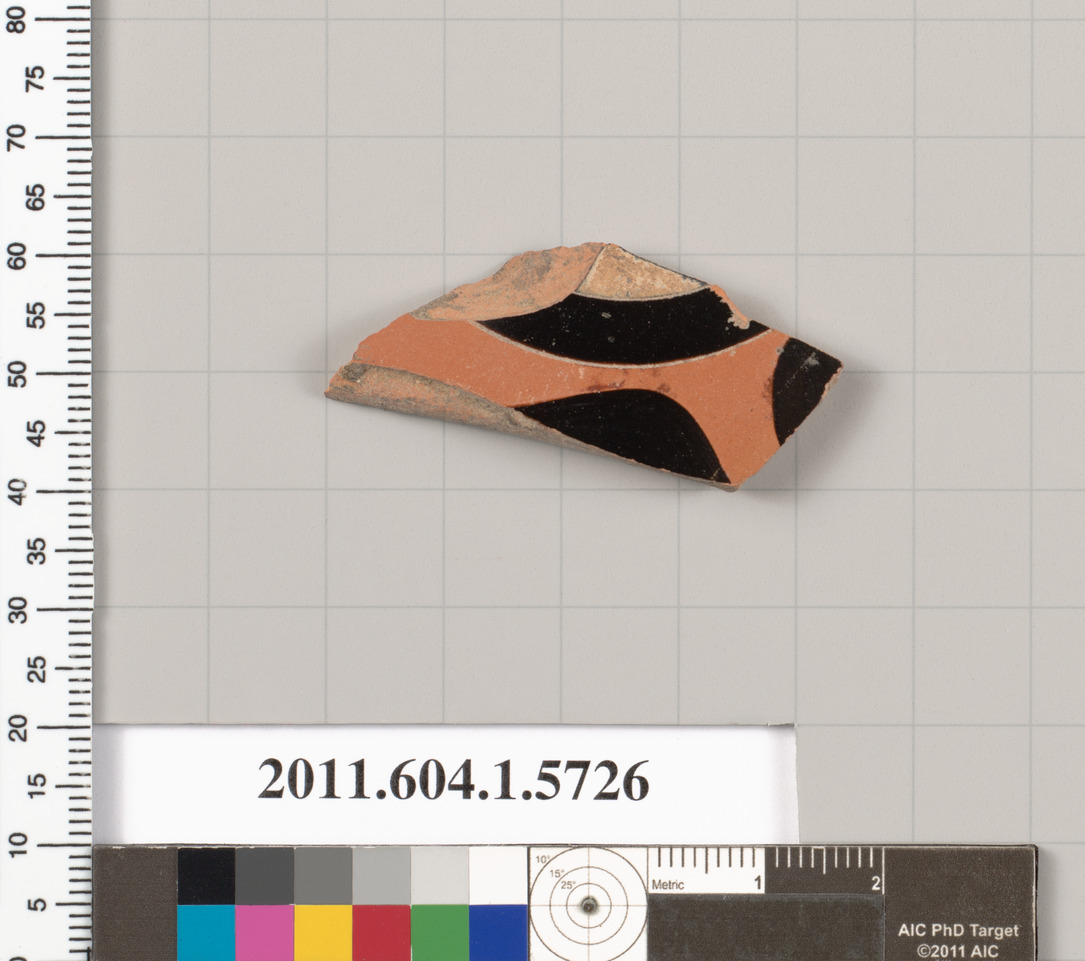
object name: kylix fragment, eye cup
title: Terracotta fragment of a kylix: eye-cup (drinking cup)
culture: greek, attic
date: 525-510 BCE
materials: terracotta